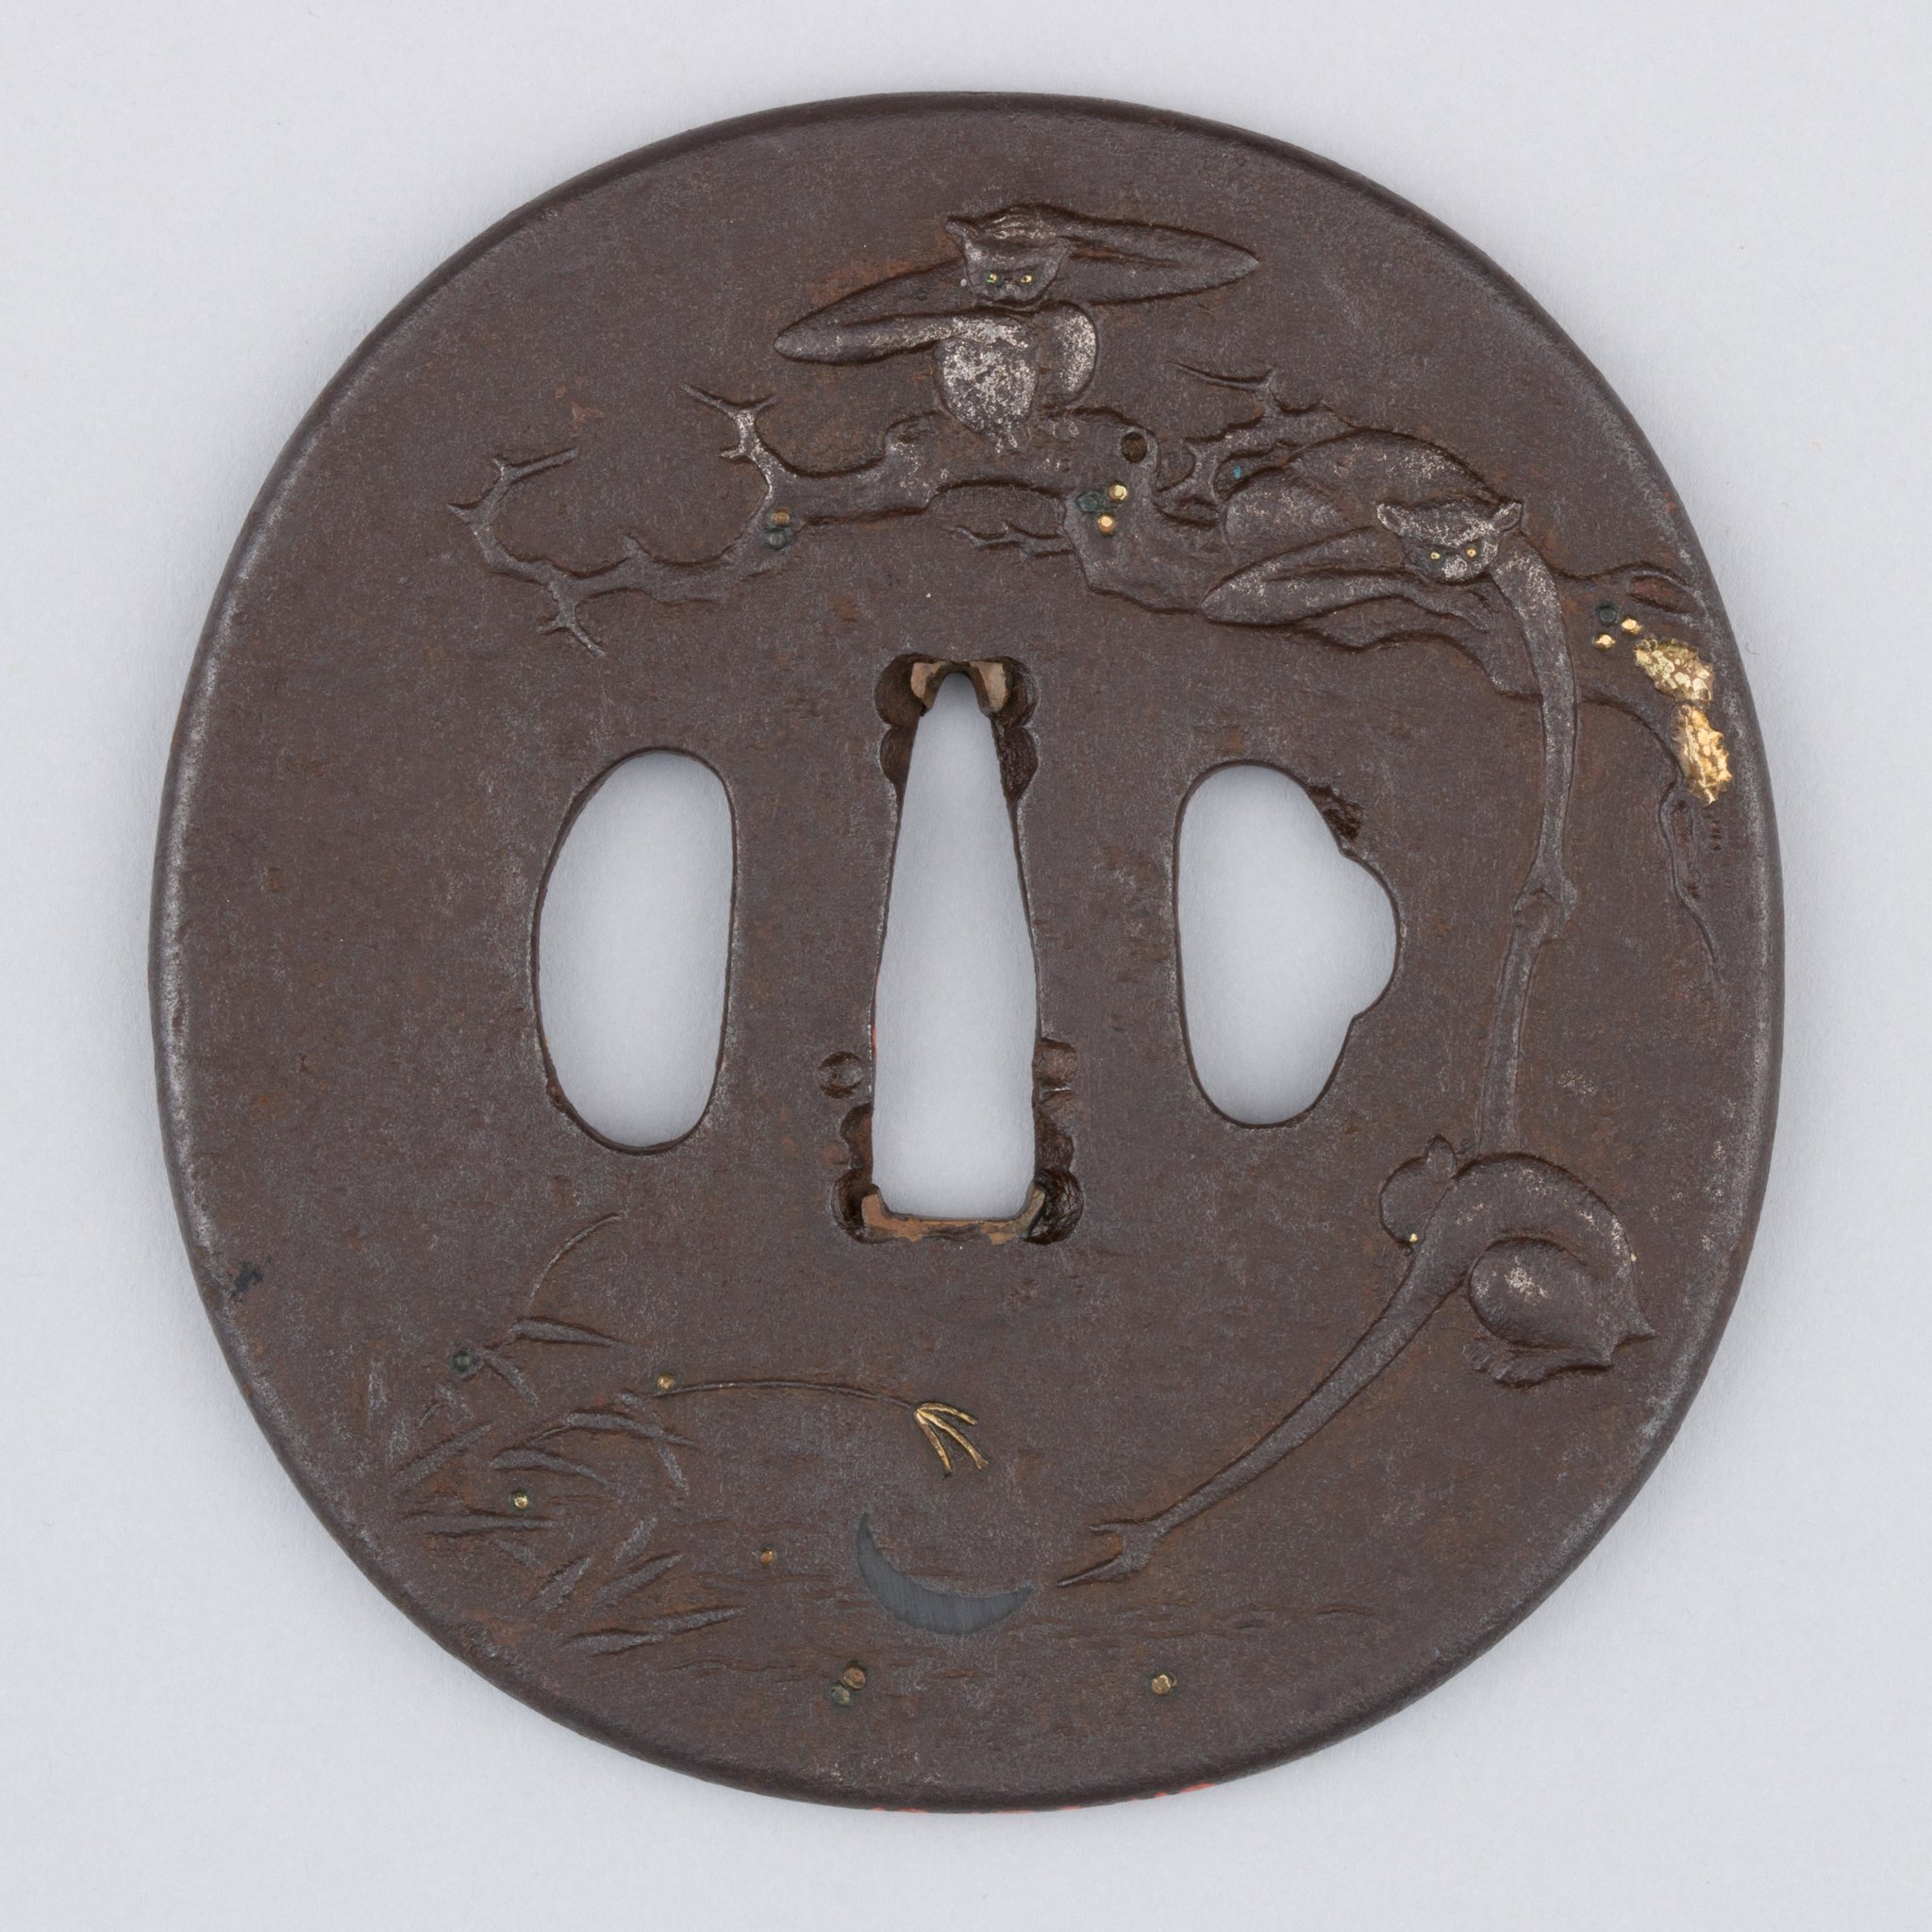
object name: sword guard tsuba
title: Sword Guard (Tsuba)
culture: japanese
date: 1615-1868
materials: copper, iron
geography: japan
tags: monkeys